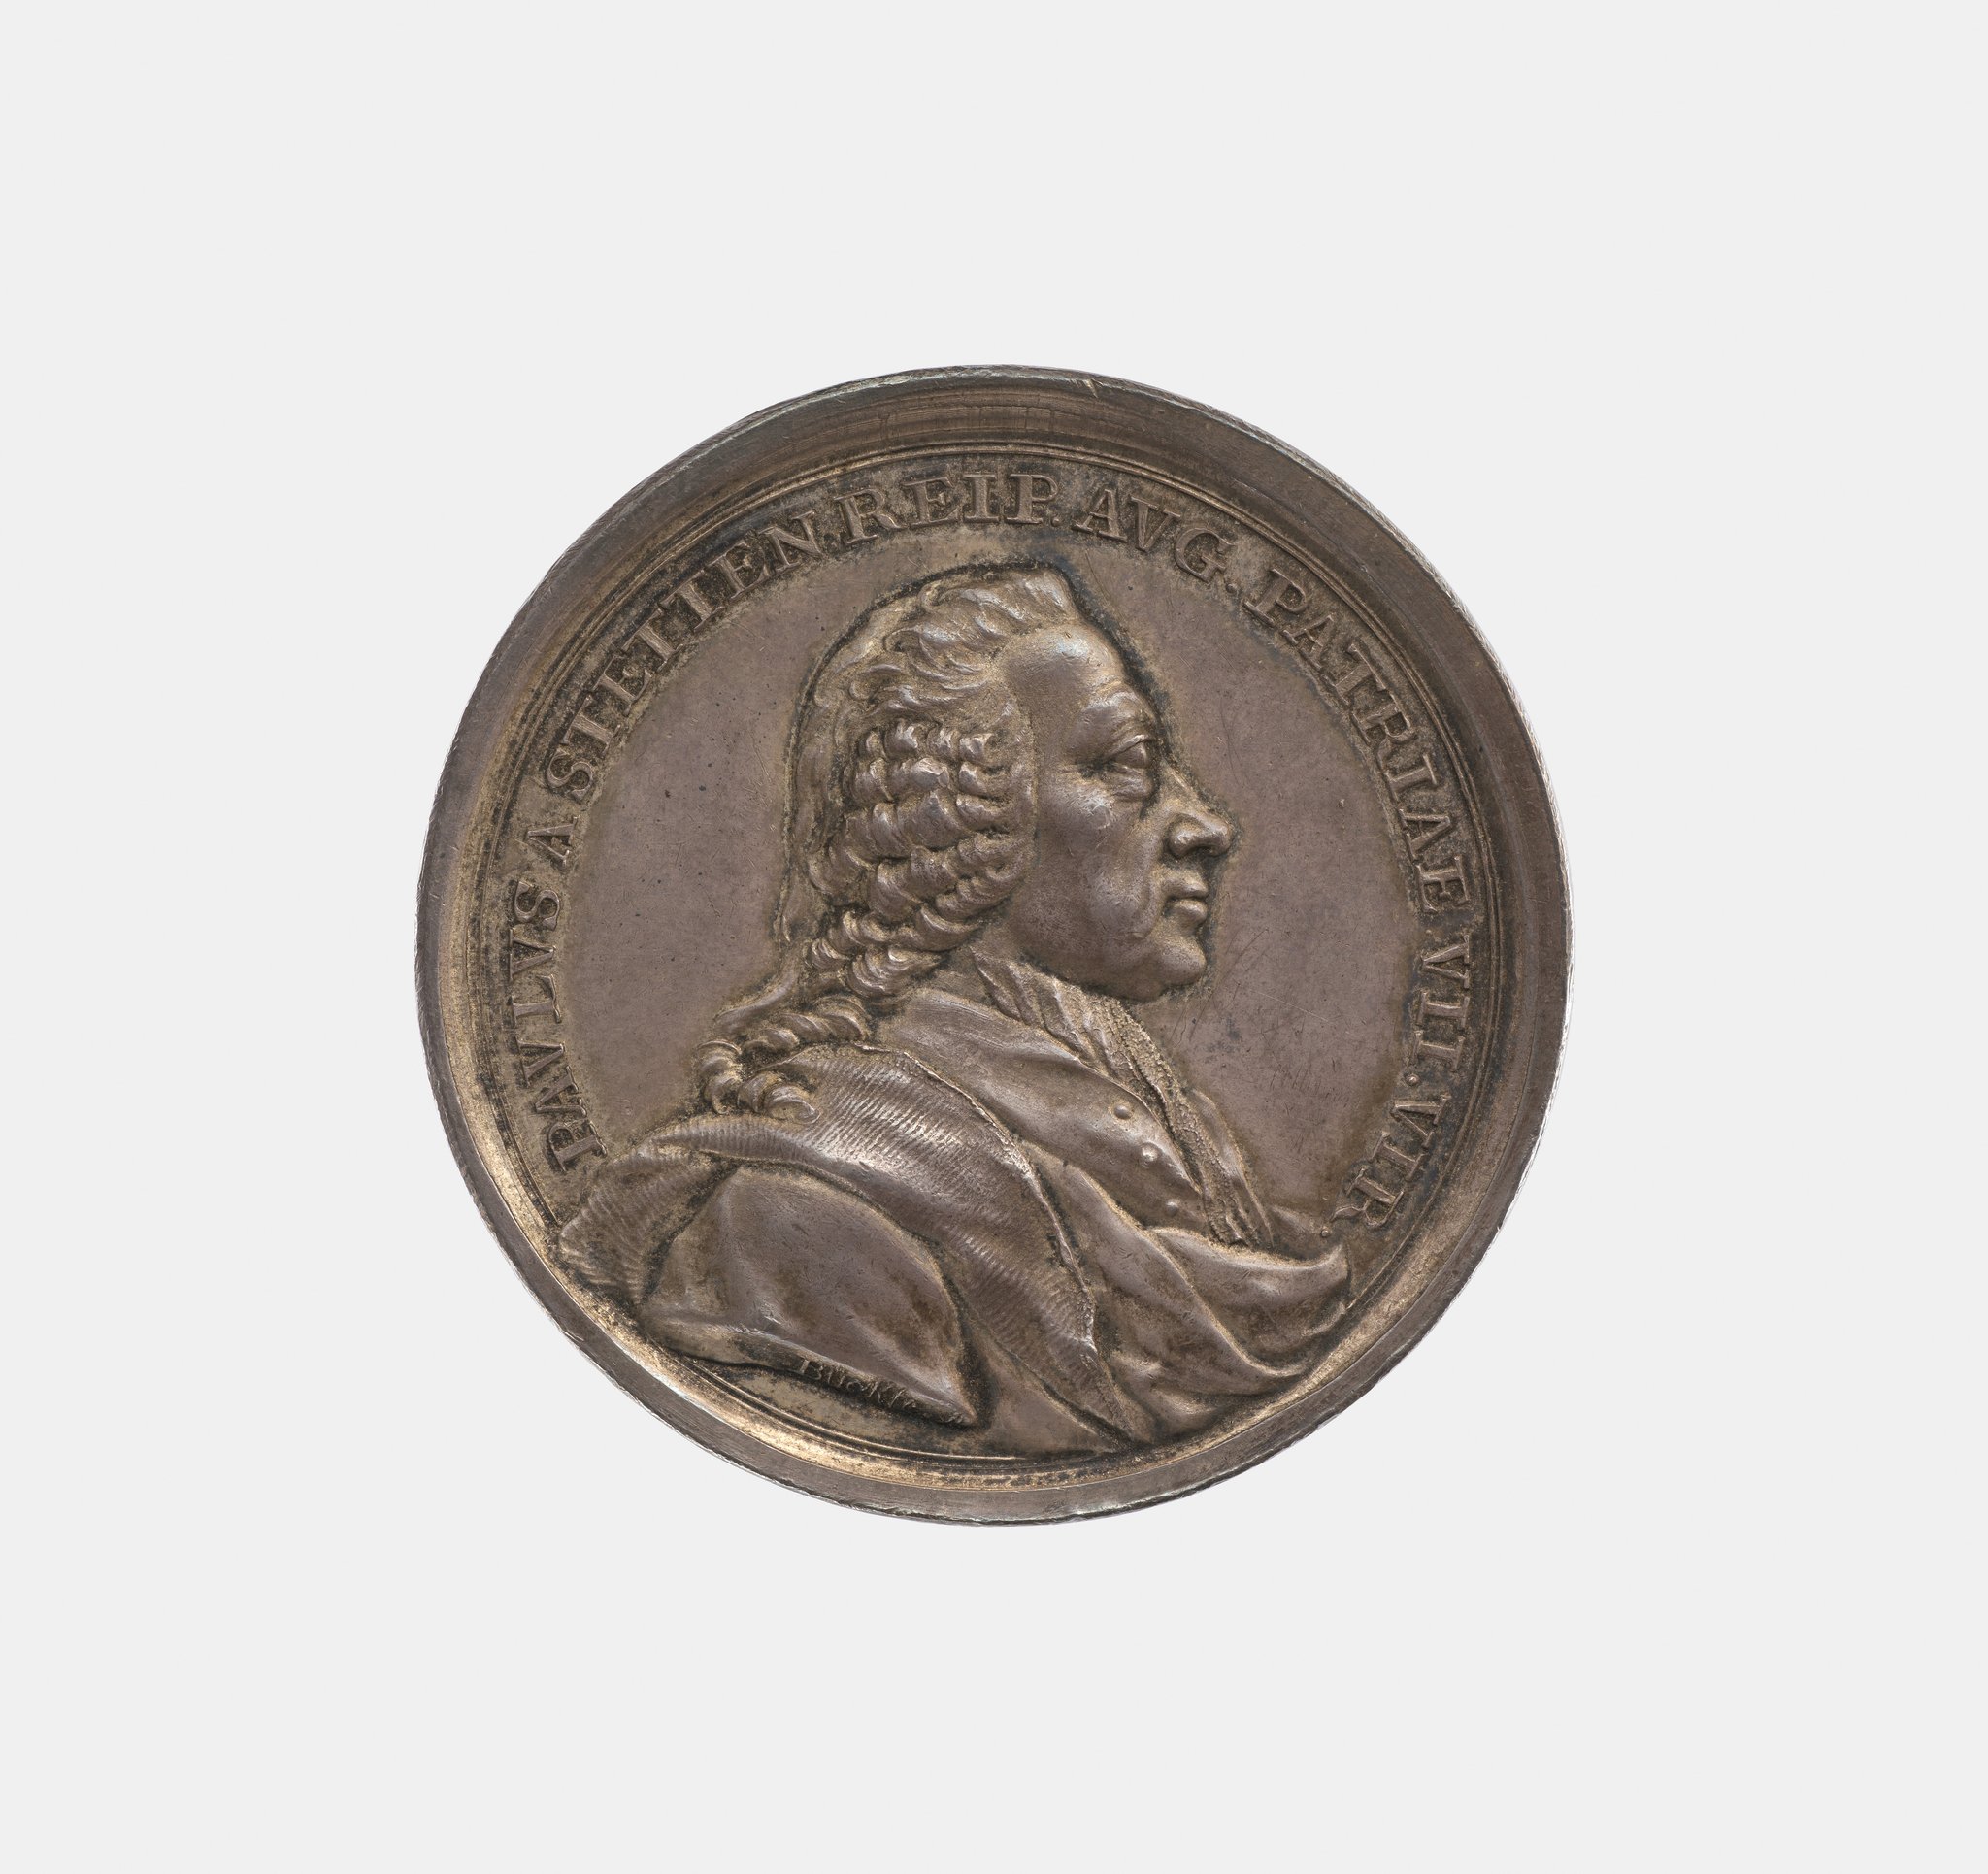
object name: medal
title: David and Paul von Stetten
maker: johann martin bückle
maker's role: artist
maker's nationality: german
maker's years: 1742-1811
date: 1767-1833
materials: silver